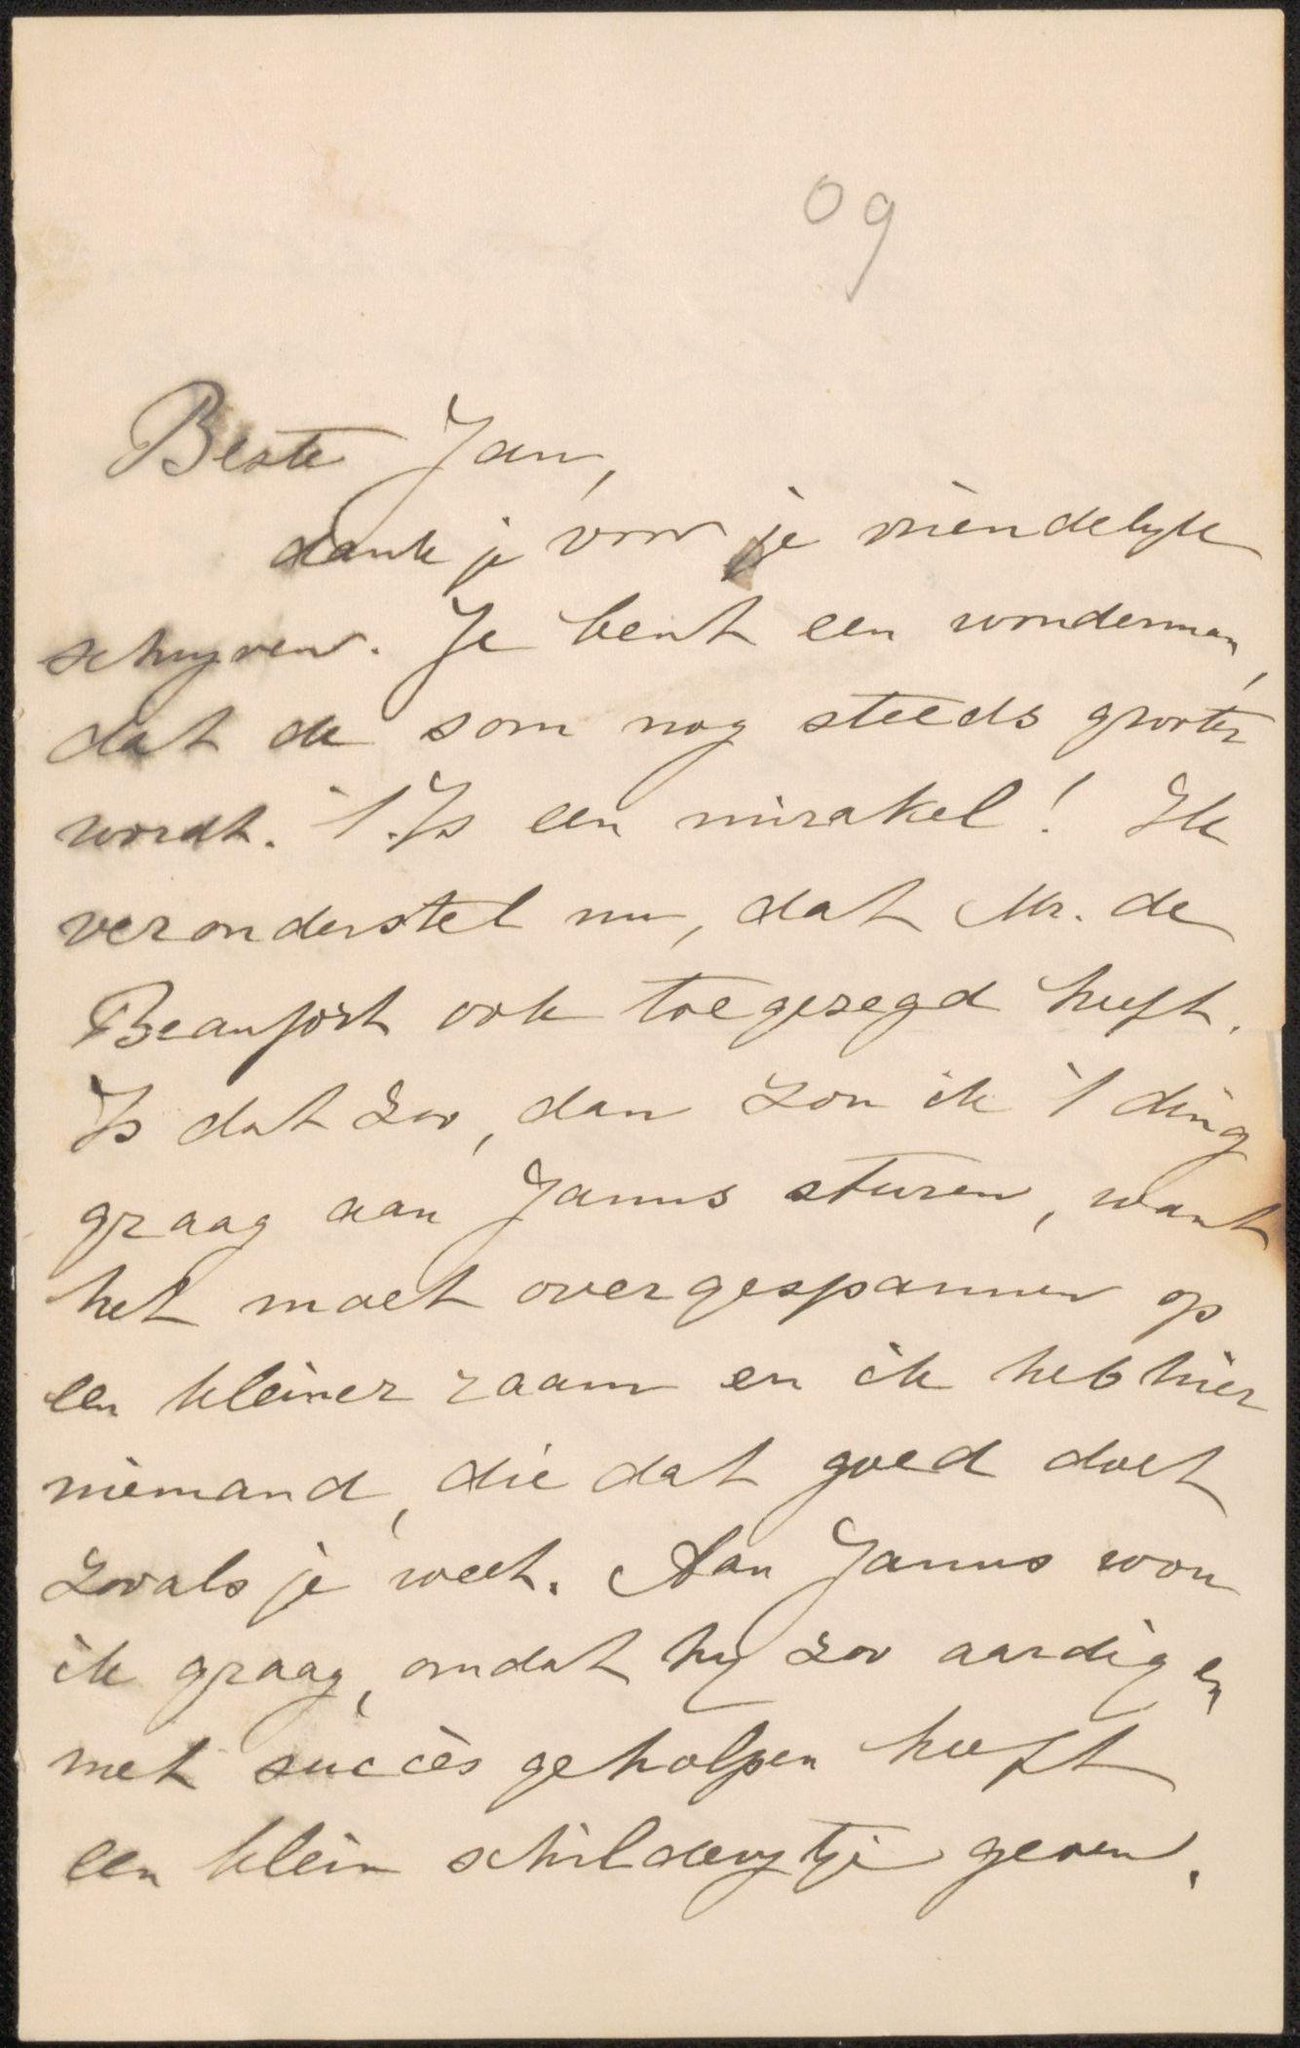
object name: letter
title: Brief aan Jan Veth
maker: wally moes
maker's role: draughtsman, print maker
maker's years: 1856-1918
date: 1909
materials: ink, paper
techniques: pen, writing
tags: painter, designer, jan veth, the hague, drawing, painting (including book-illumination, miniature-painting), historical persons (portraits and scenes from the life)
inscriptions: collector's mark: ‘RPK’